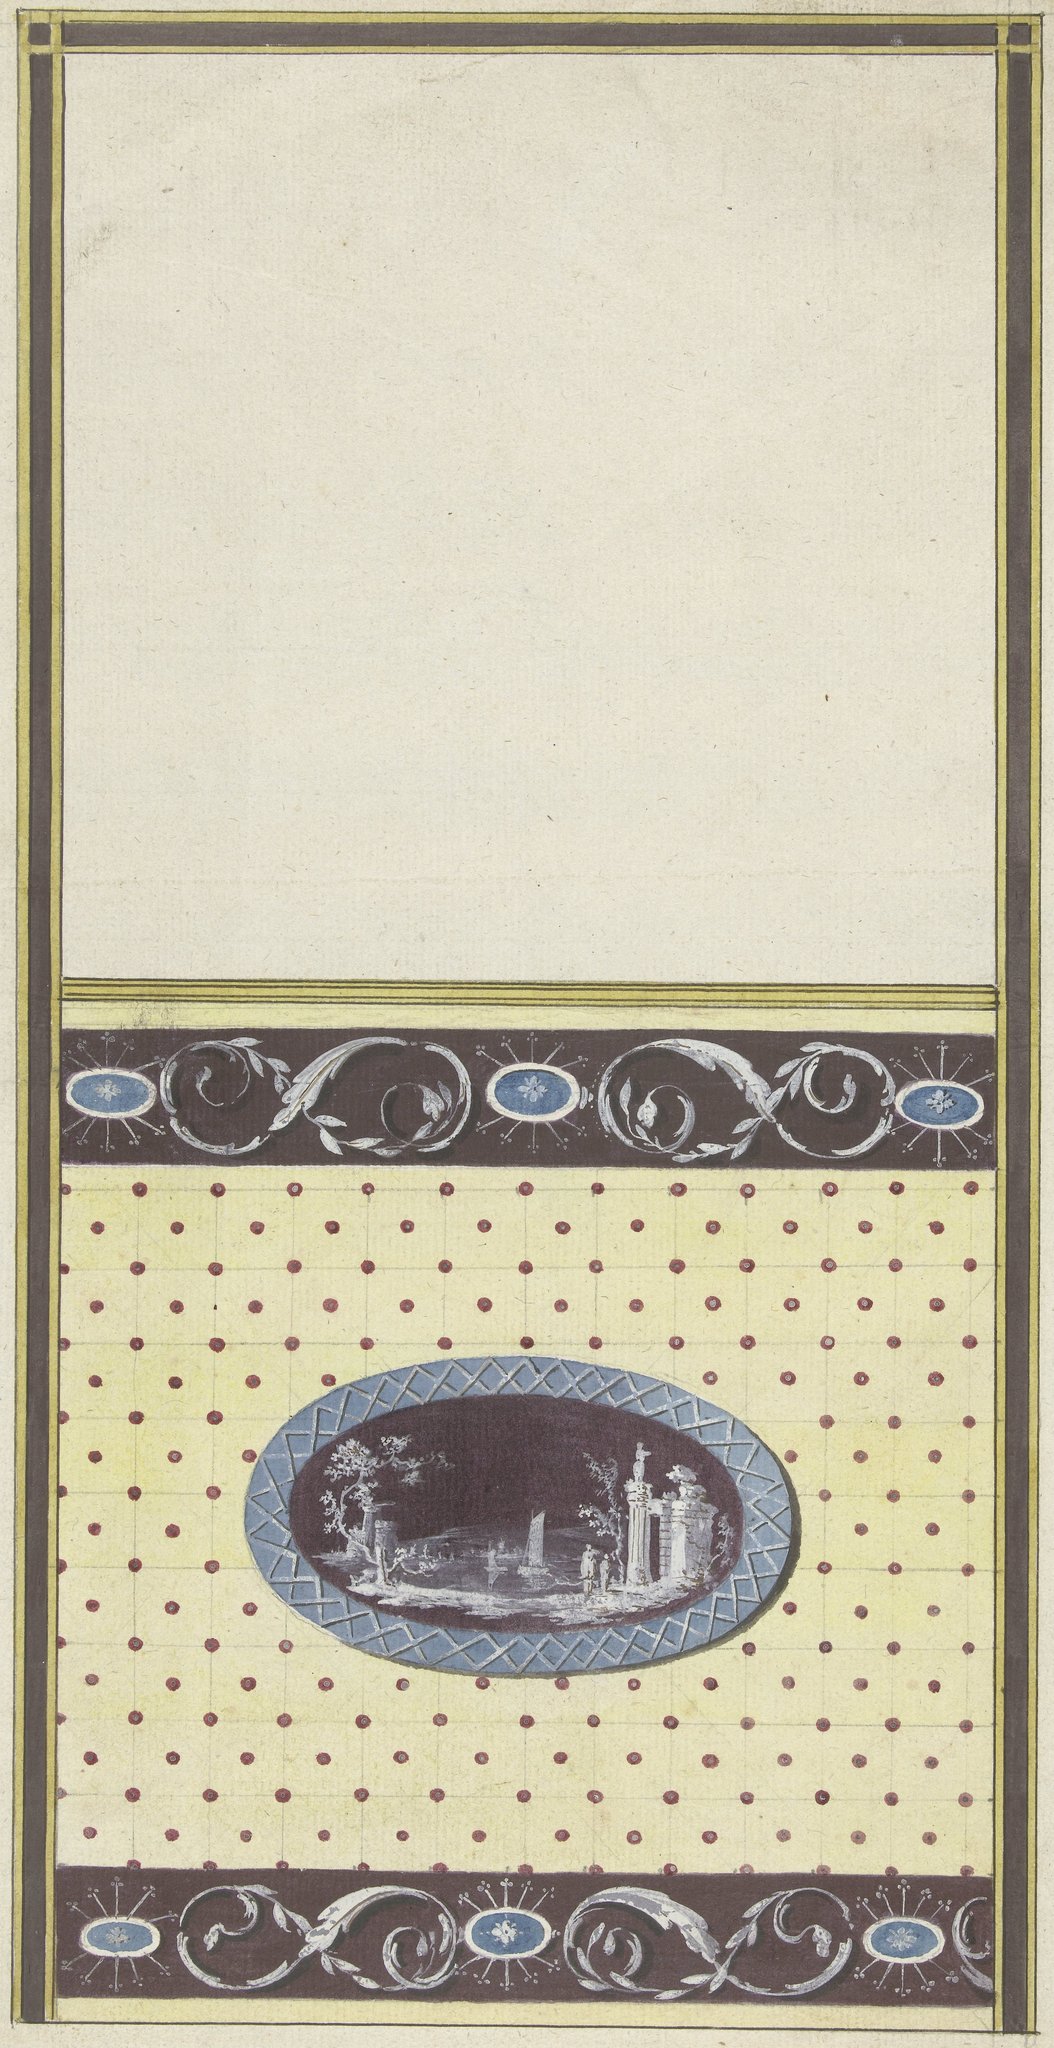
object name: design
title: Ontwerp voor kamerversiering met verticaal twee panelen, de onderste met een ruïnelandschap in een liggend ovaal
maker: abraham meertens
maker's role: draughtsman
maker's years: 1757-1823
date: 1767-1823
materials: paint, ink, paper, pencil, watercolor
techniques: brush, pen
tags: wall-covering